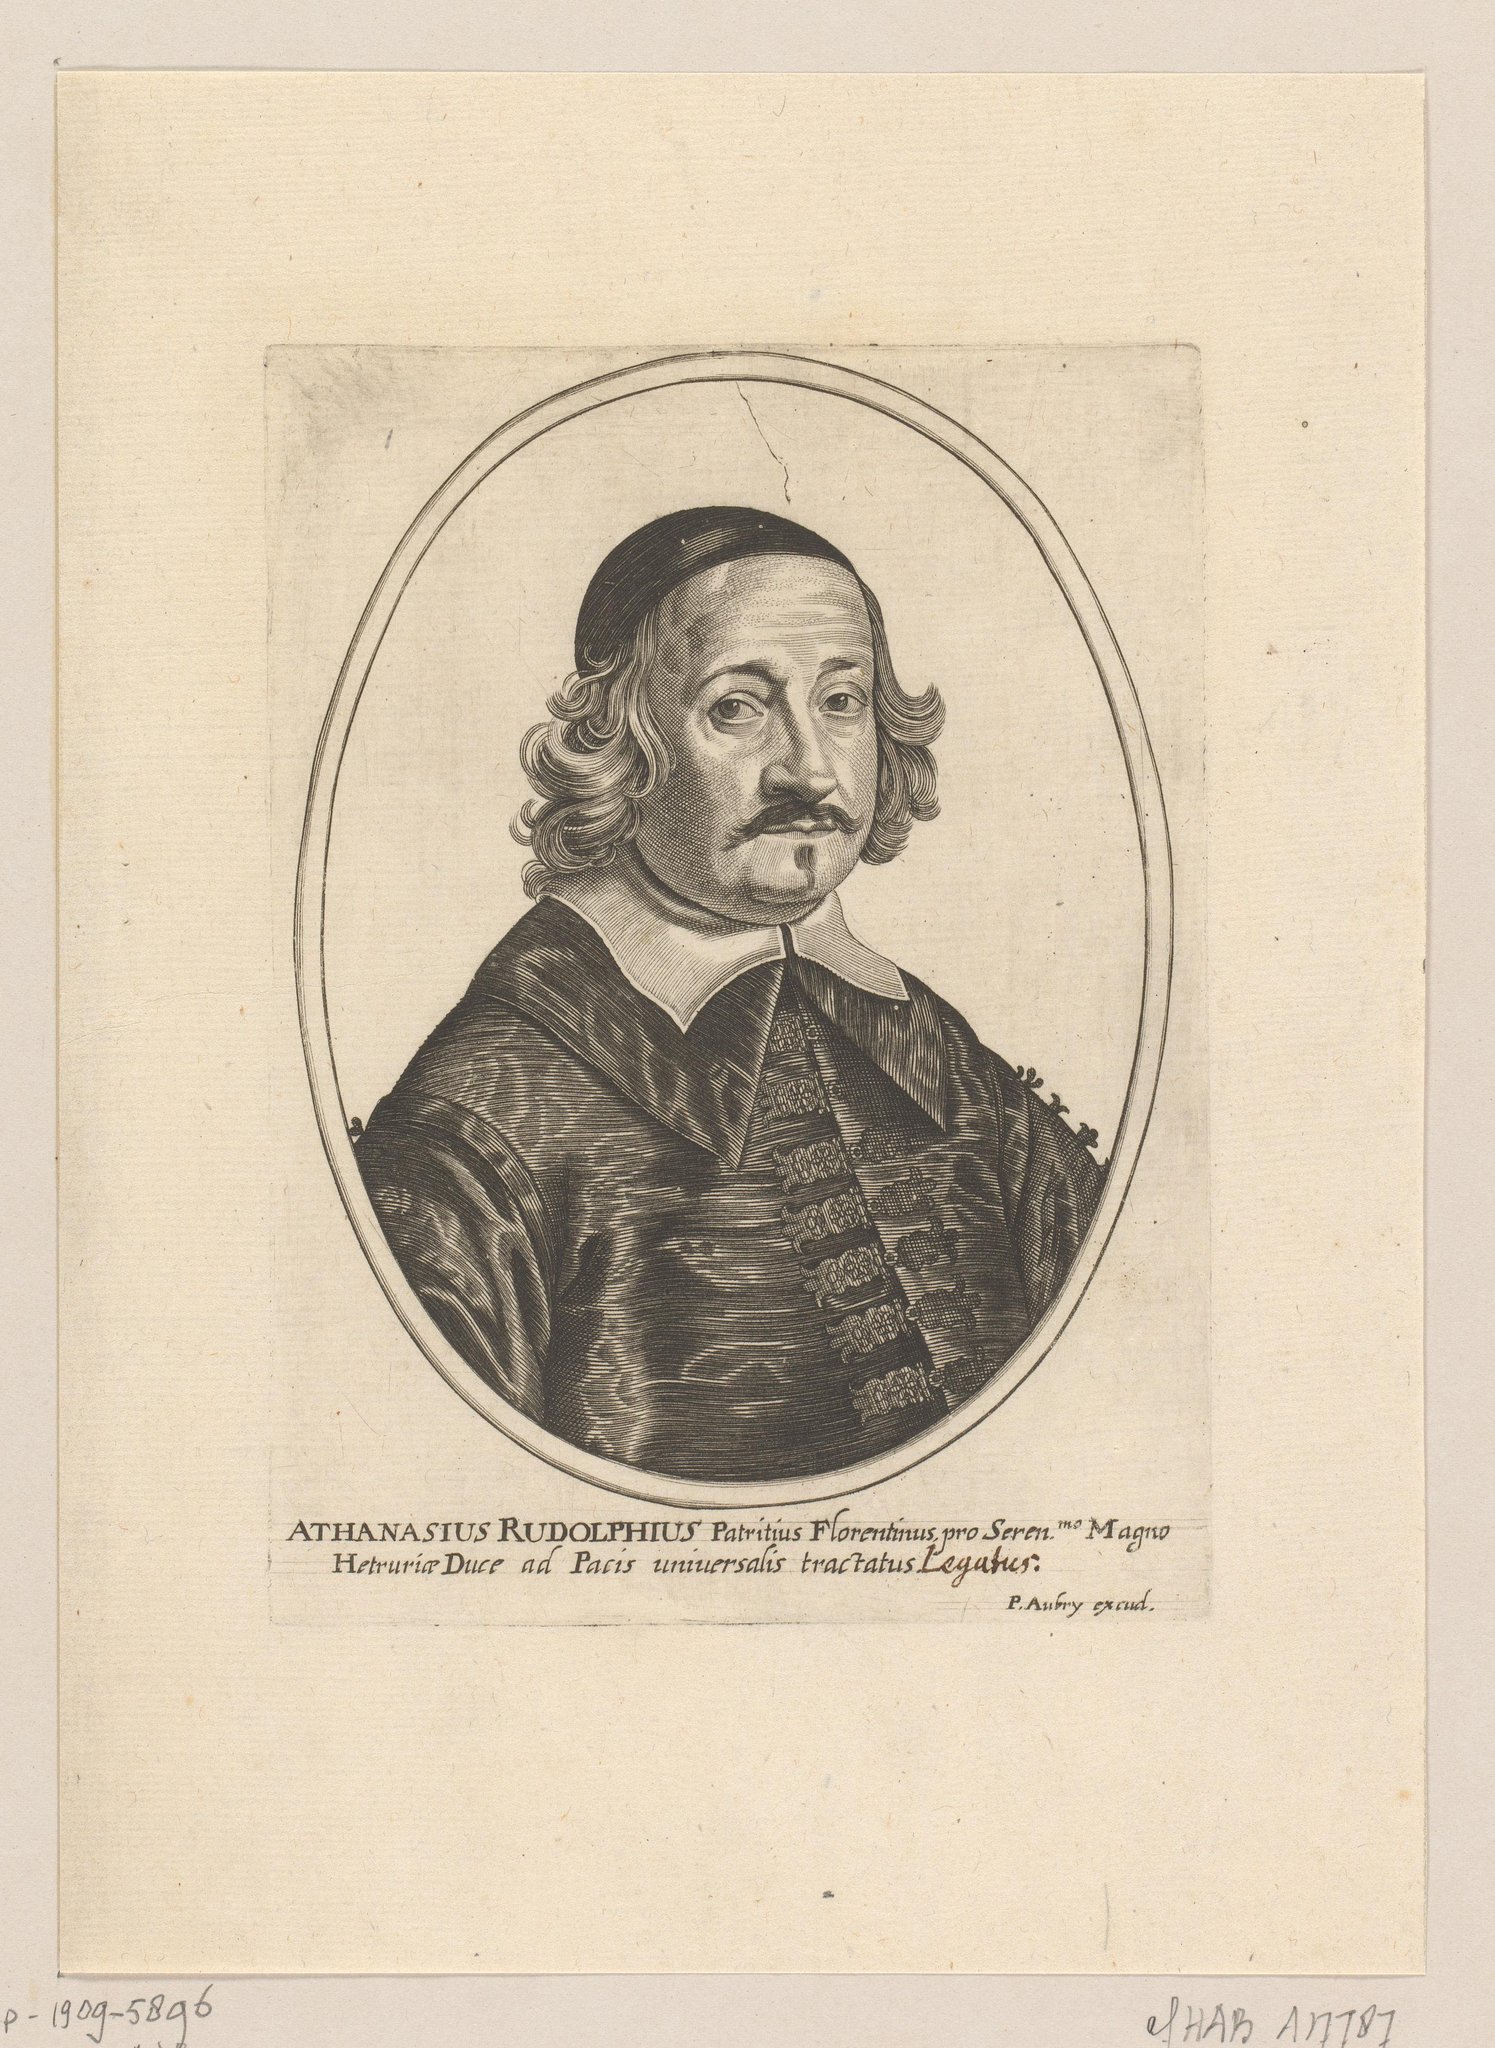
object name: print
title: Portret van Atanasio Rodulfi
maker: Anonymous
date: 1606-1686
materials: paper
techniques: engraving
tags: historical persons, diplomacy, diplomat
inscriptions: inscription: ‘Legatus’, number: ‘747’, collector's mark: Lugt 2228